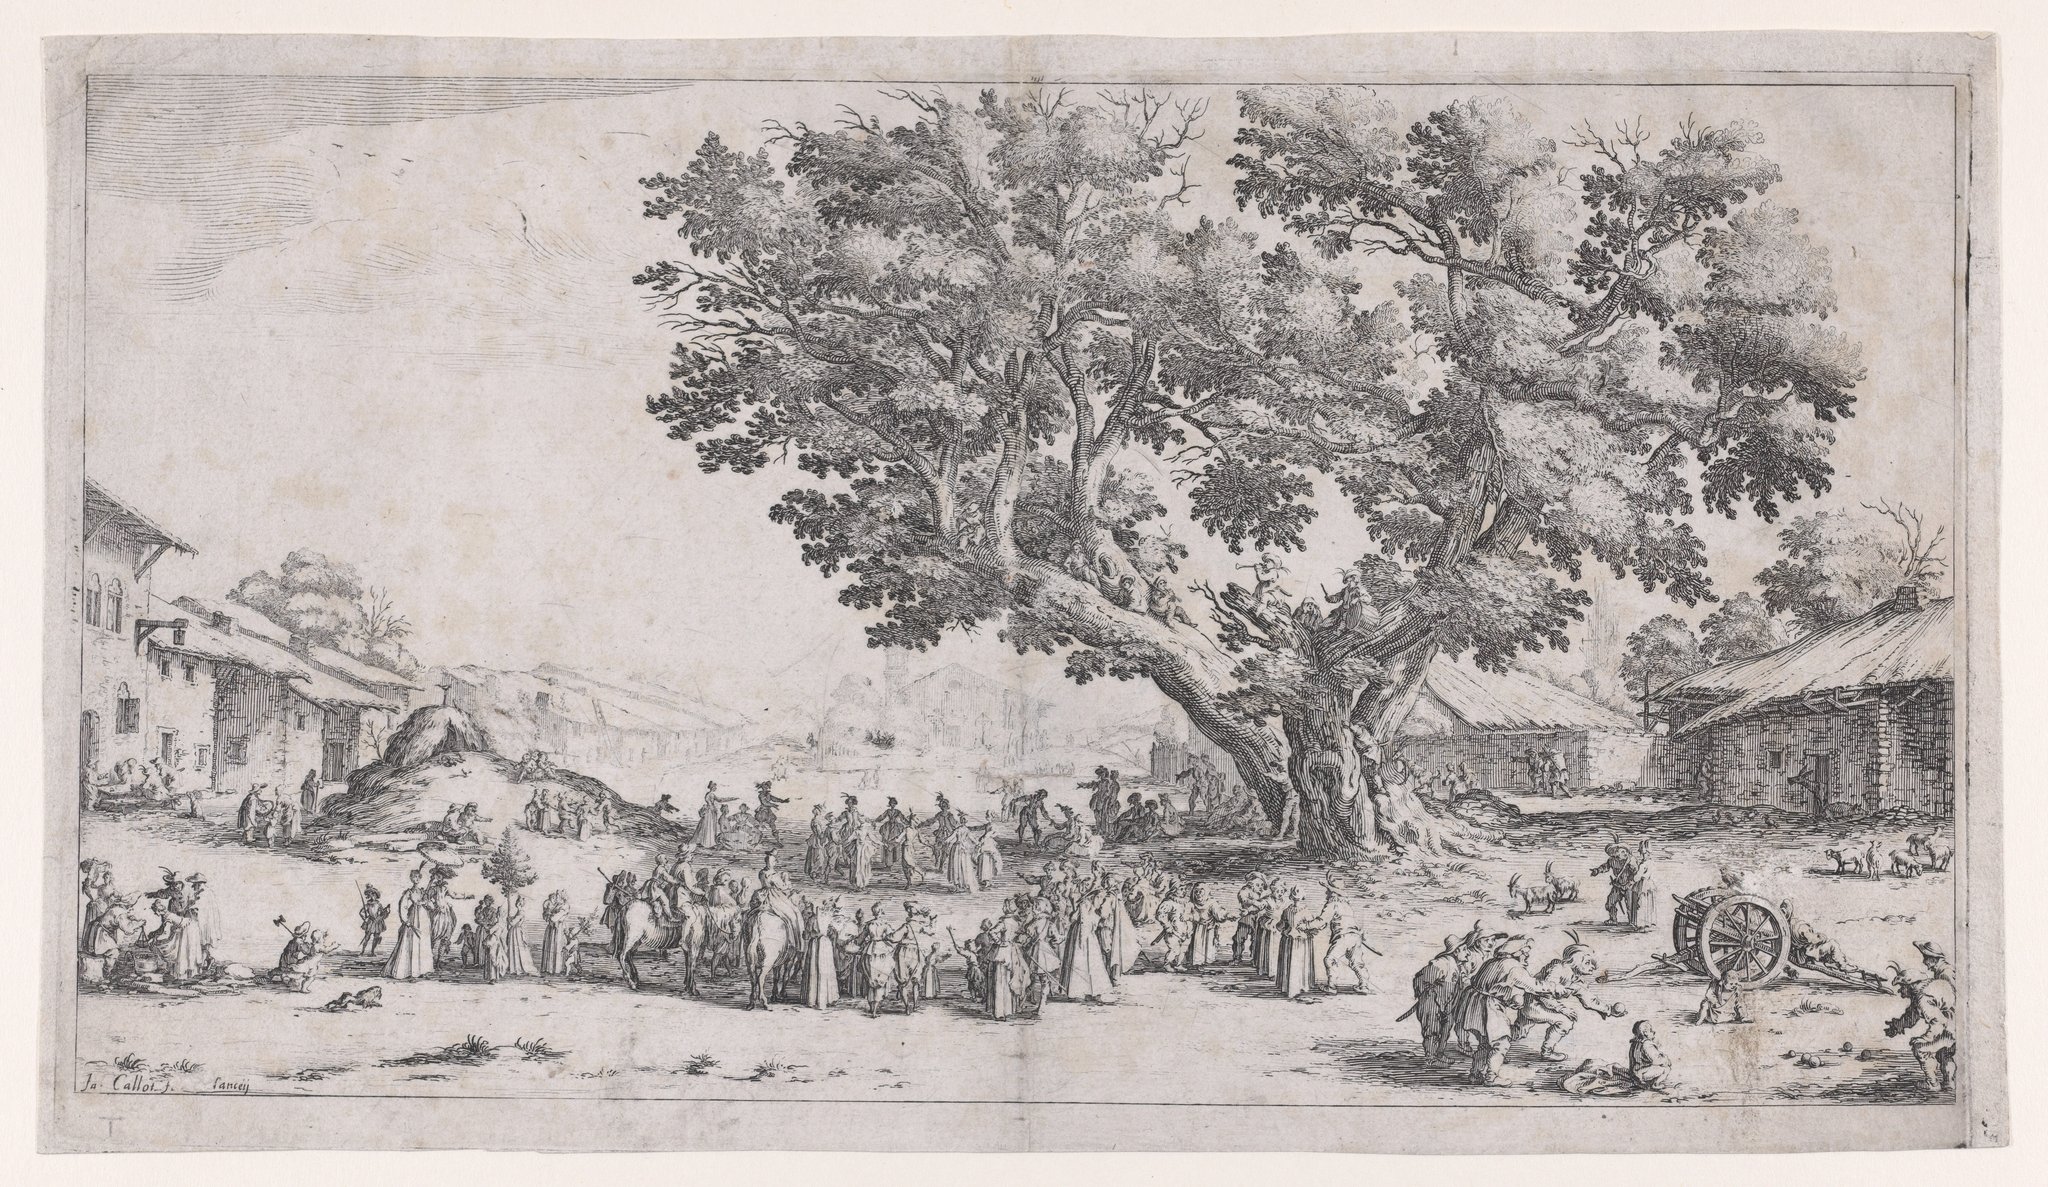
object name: print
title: La Fiore de Gondreville pièce appelée aussi La Fête du Village, La Petite Foire, Le Bal Champêtre, Le Jeu de Boules (The Fair at Gondreville also called The Village Festival, The Little Fair, The Country Dance, The Game of Bowls)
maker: jacques callot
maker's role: artist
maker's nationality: french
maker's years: 1592-1635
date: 1624-1625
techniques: etching